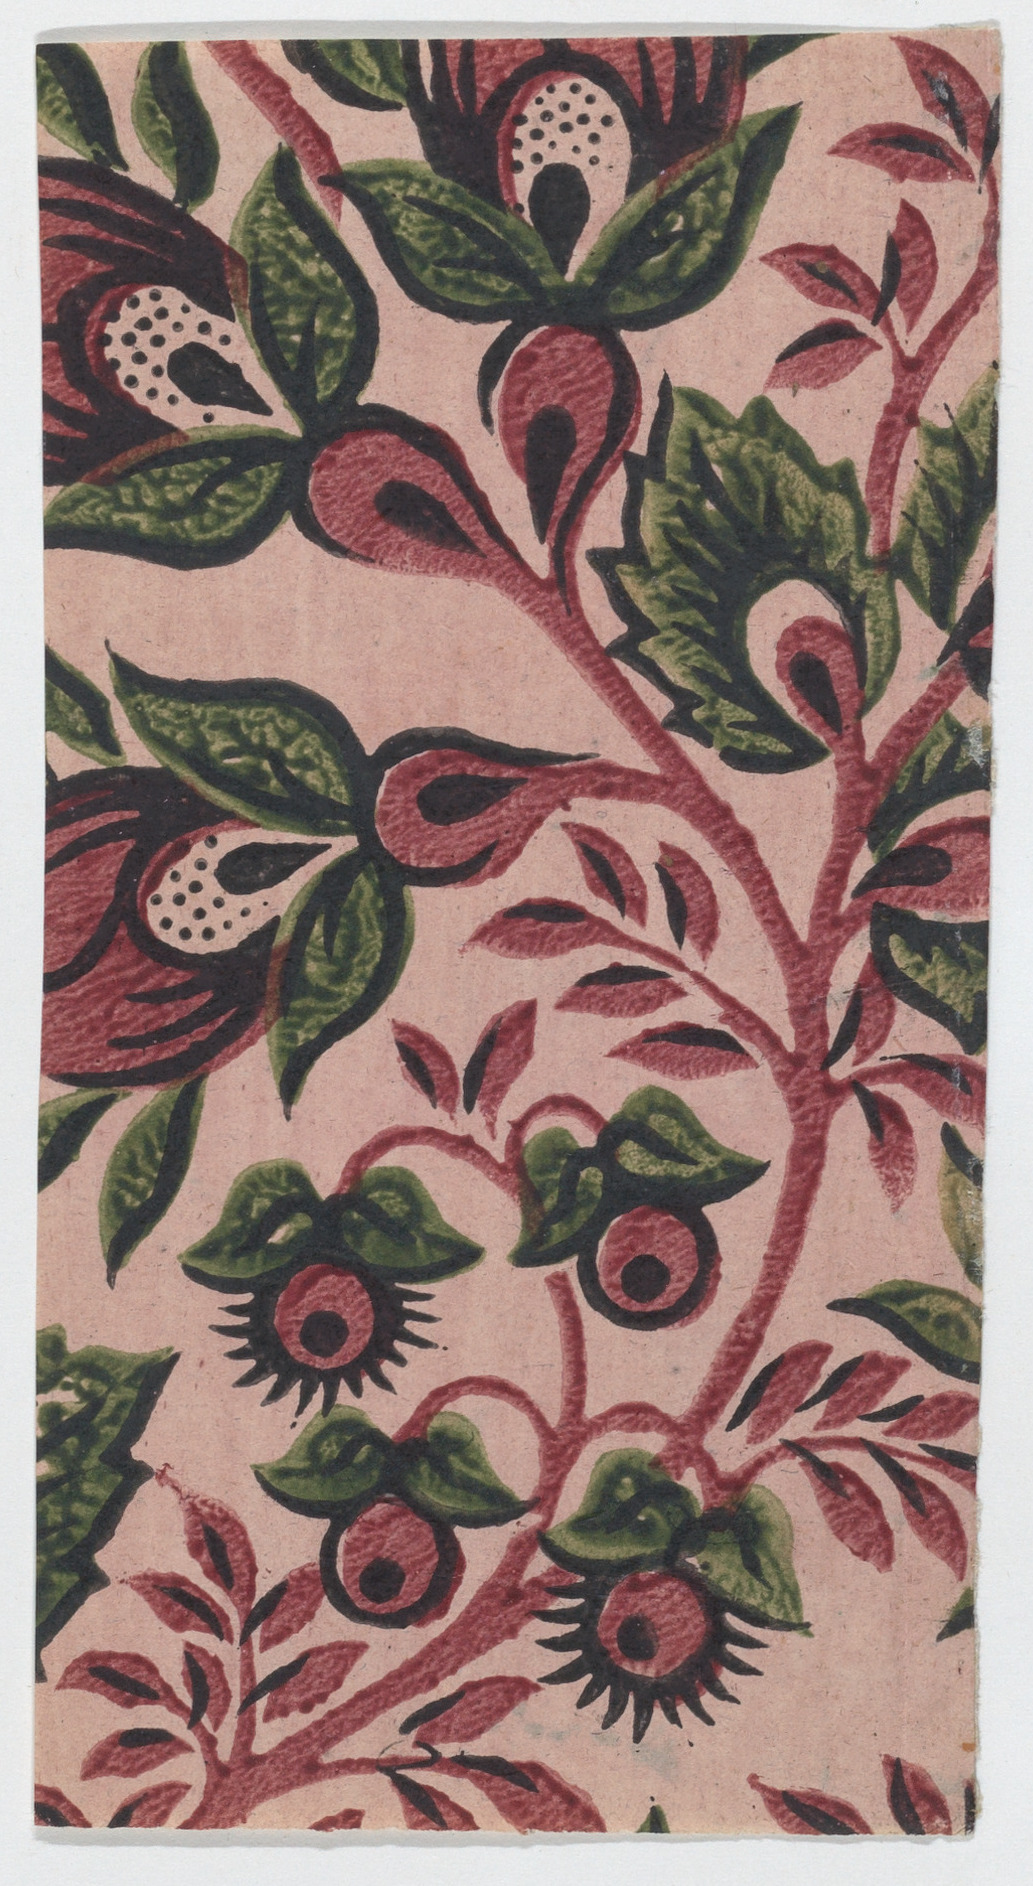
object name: print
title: Small sheet with overall floral pattern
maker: Anonymous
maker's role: artist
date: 1767-1866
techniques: relief print